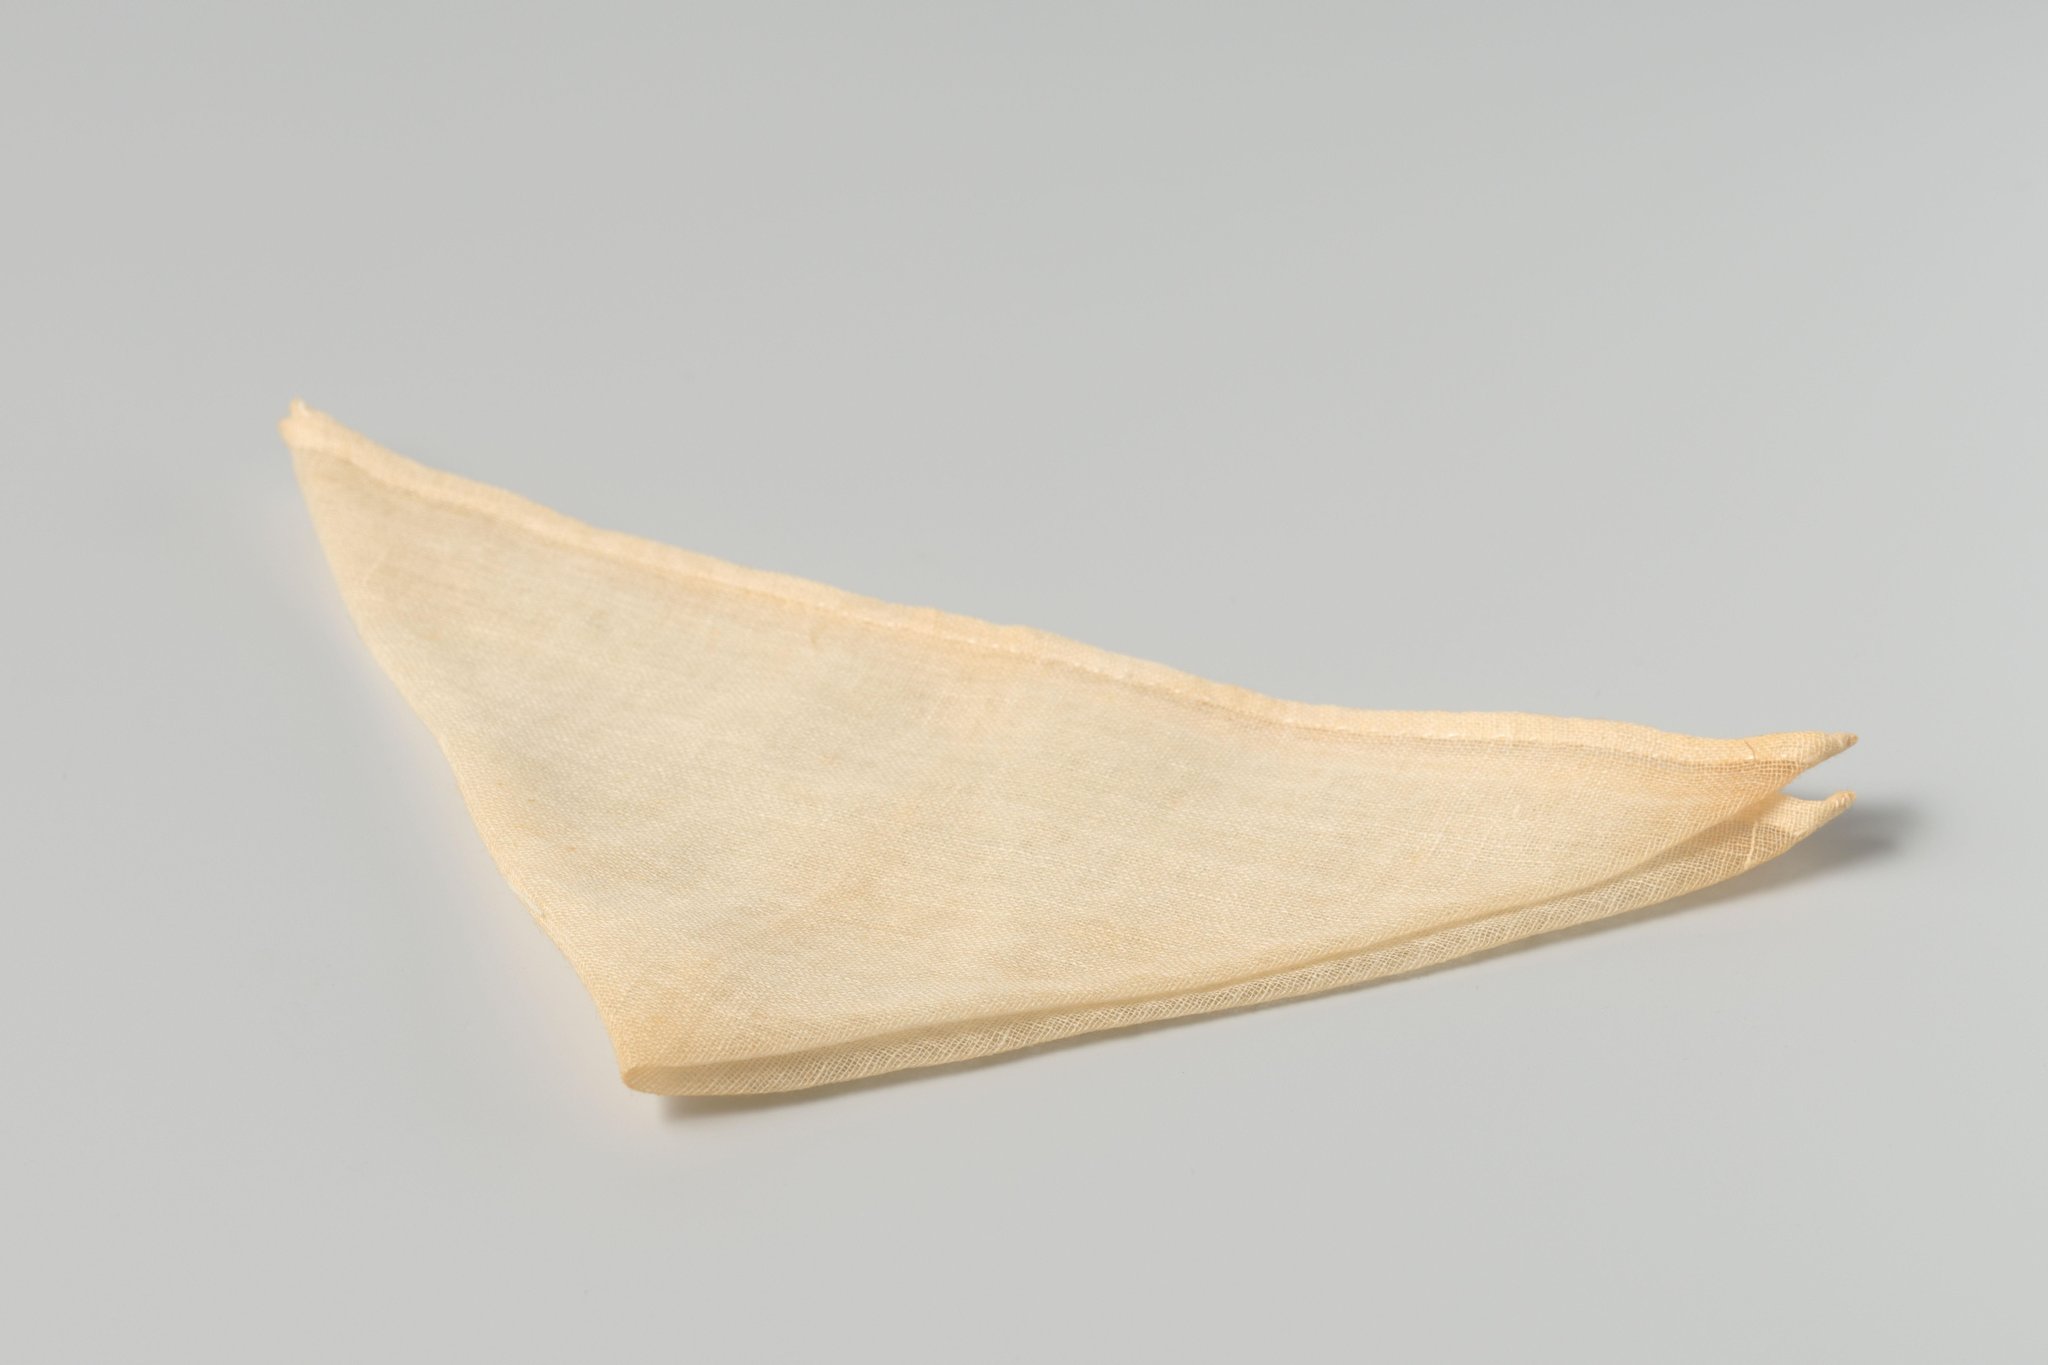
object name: miniature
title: Doek van linnen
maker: Anonymous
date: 1676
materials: linen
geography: netherlands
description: Doek van fijn linnen, vierkant, aan alle zijden voorzien van een fijne zoom.